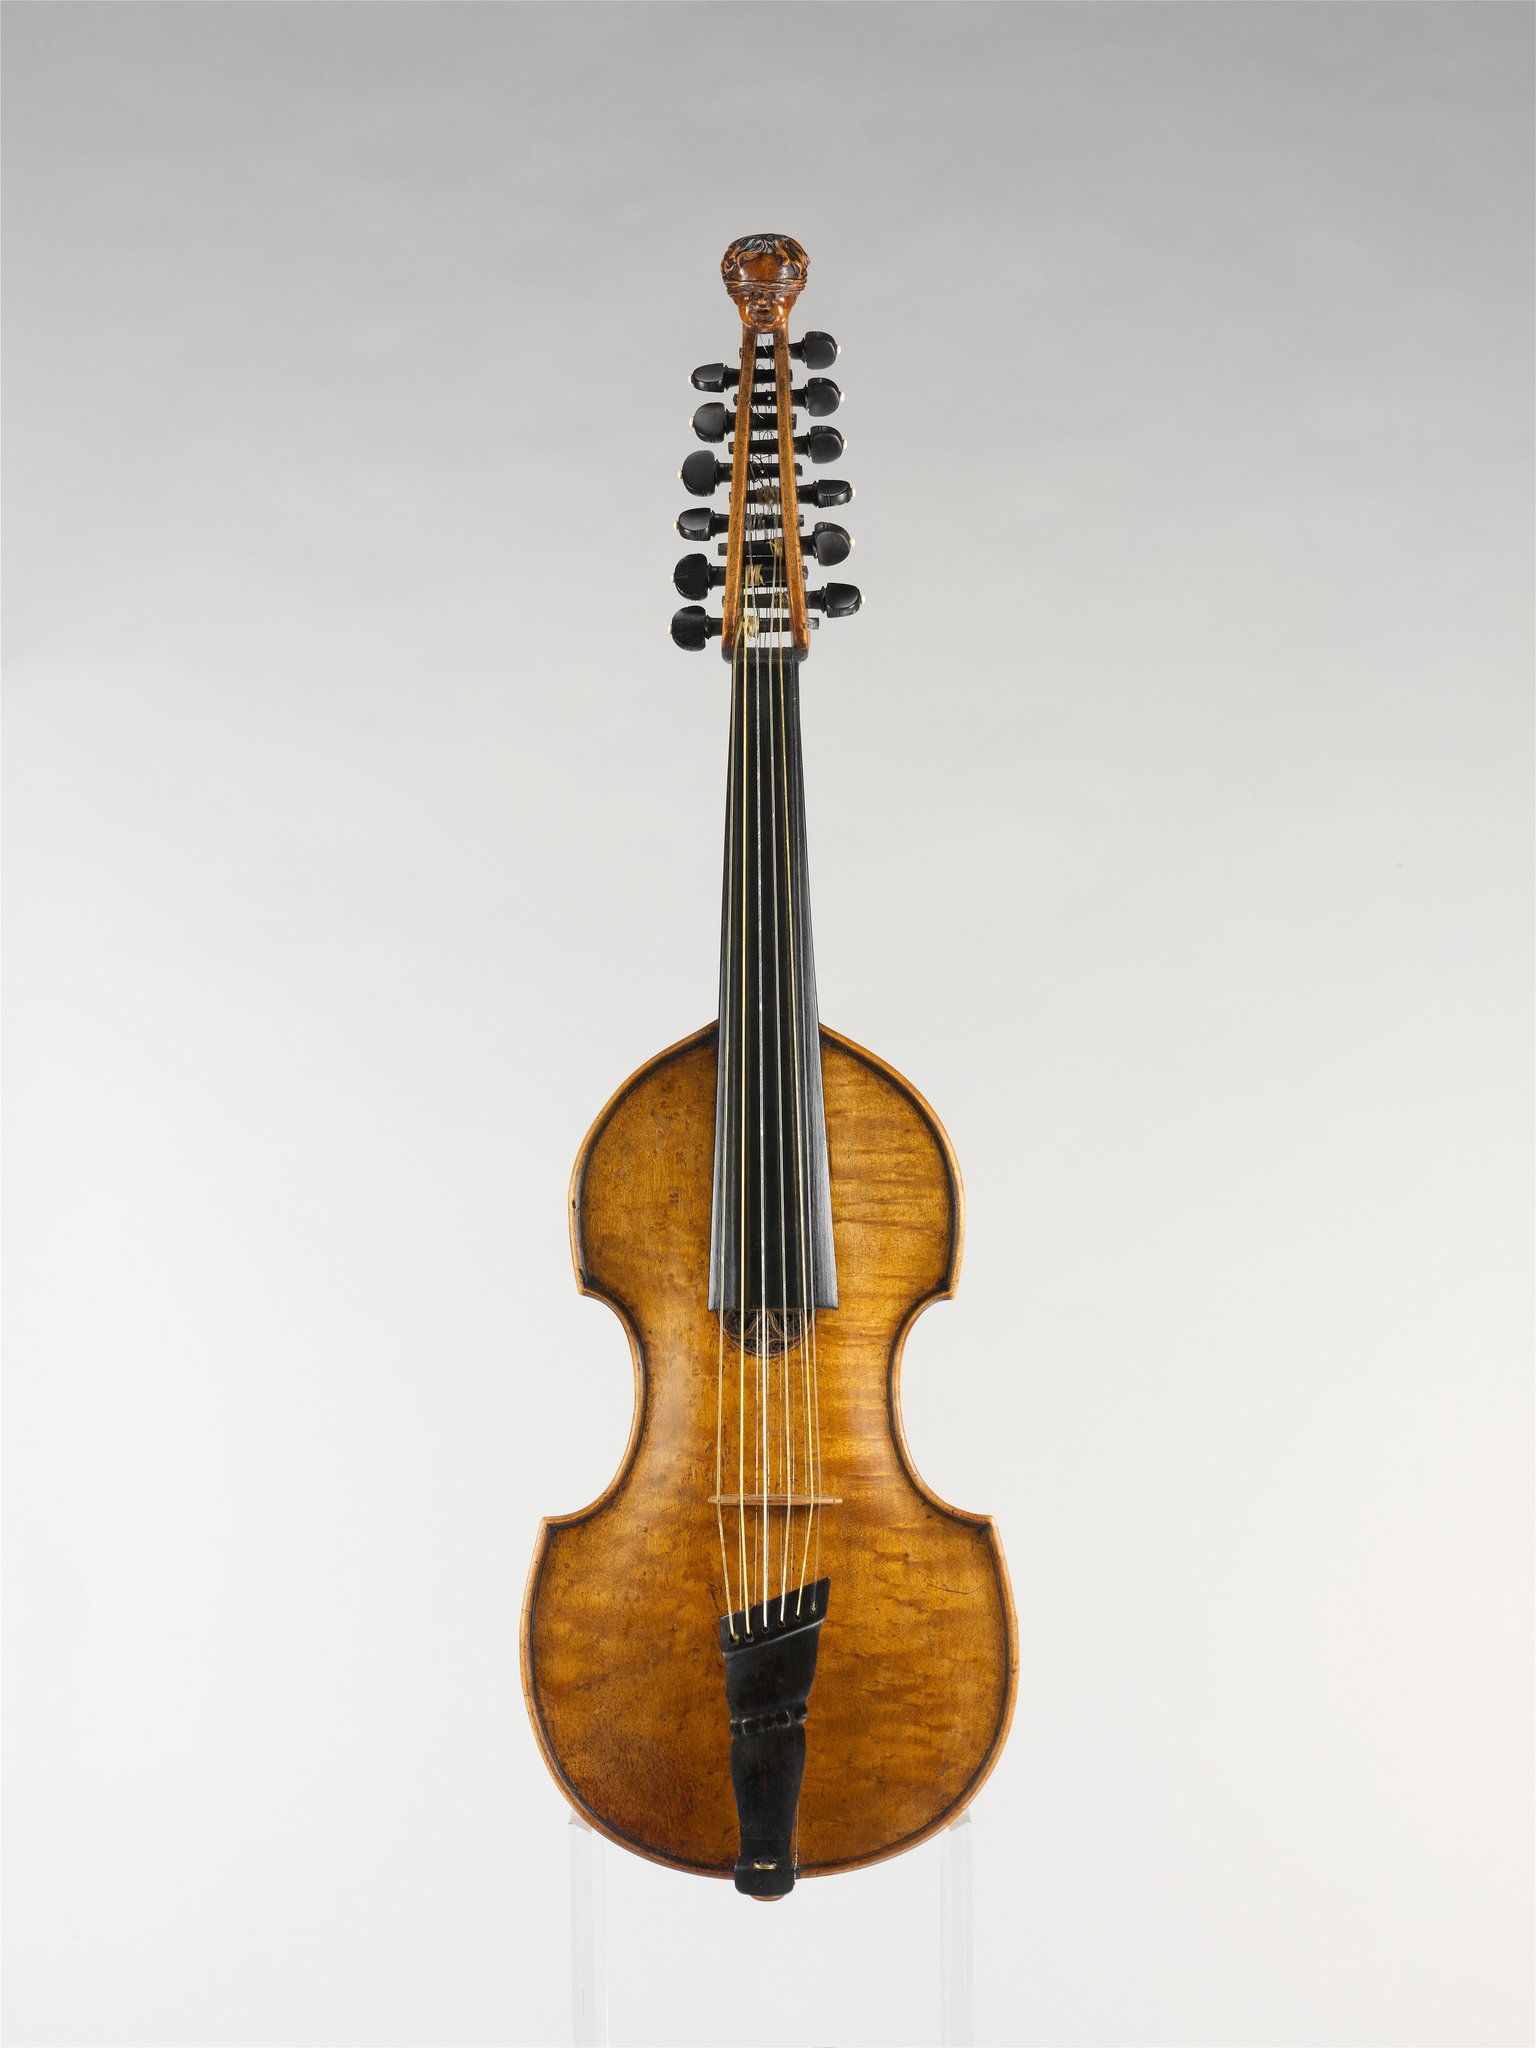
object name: mute viola d'amore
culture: austrian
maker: daniel achatius stadlmann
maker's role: maker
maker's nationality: austrian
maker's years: 1690-1744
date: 1734-1766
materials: wood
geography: austria